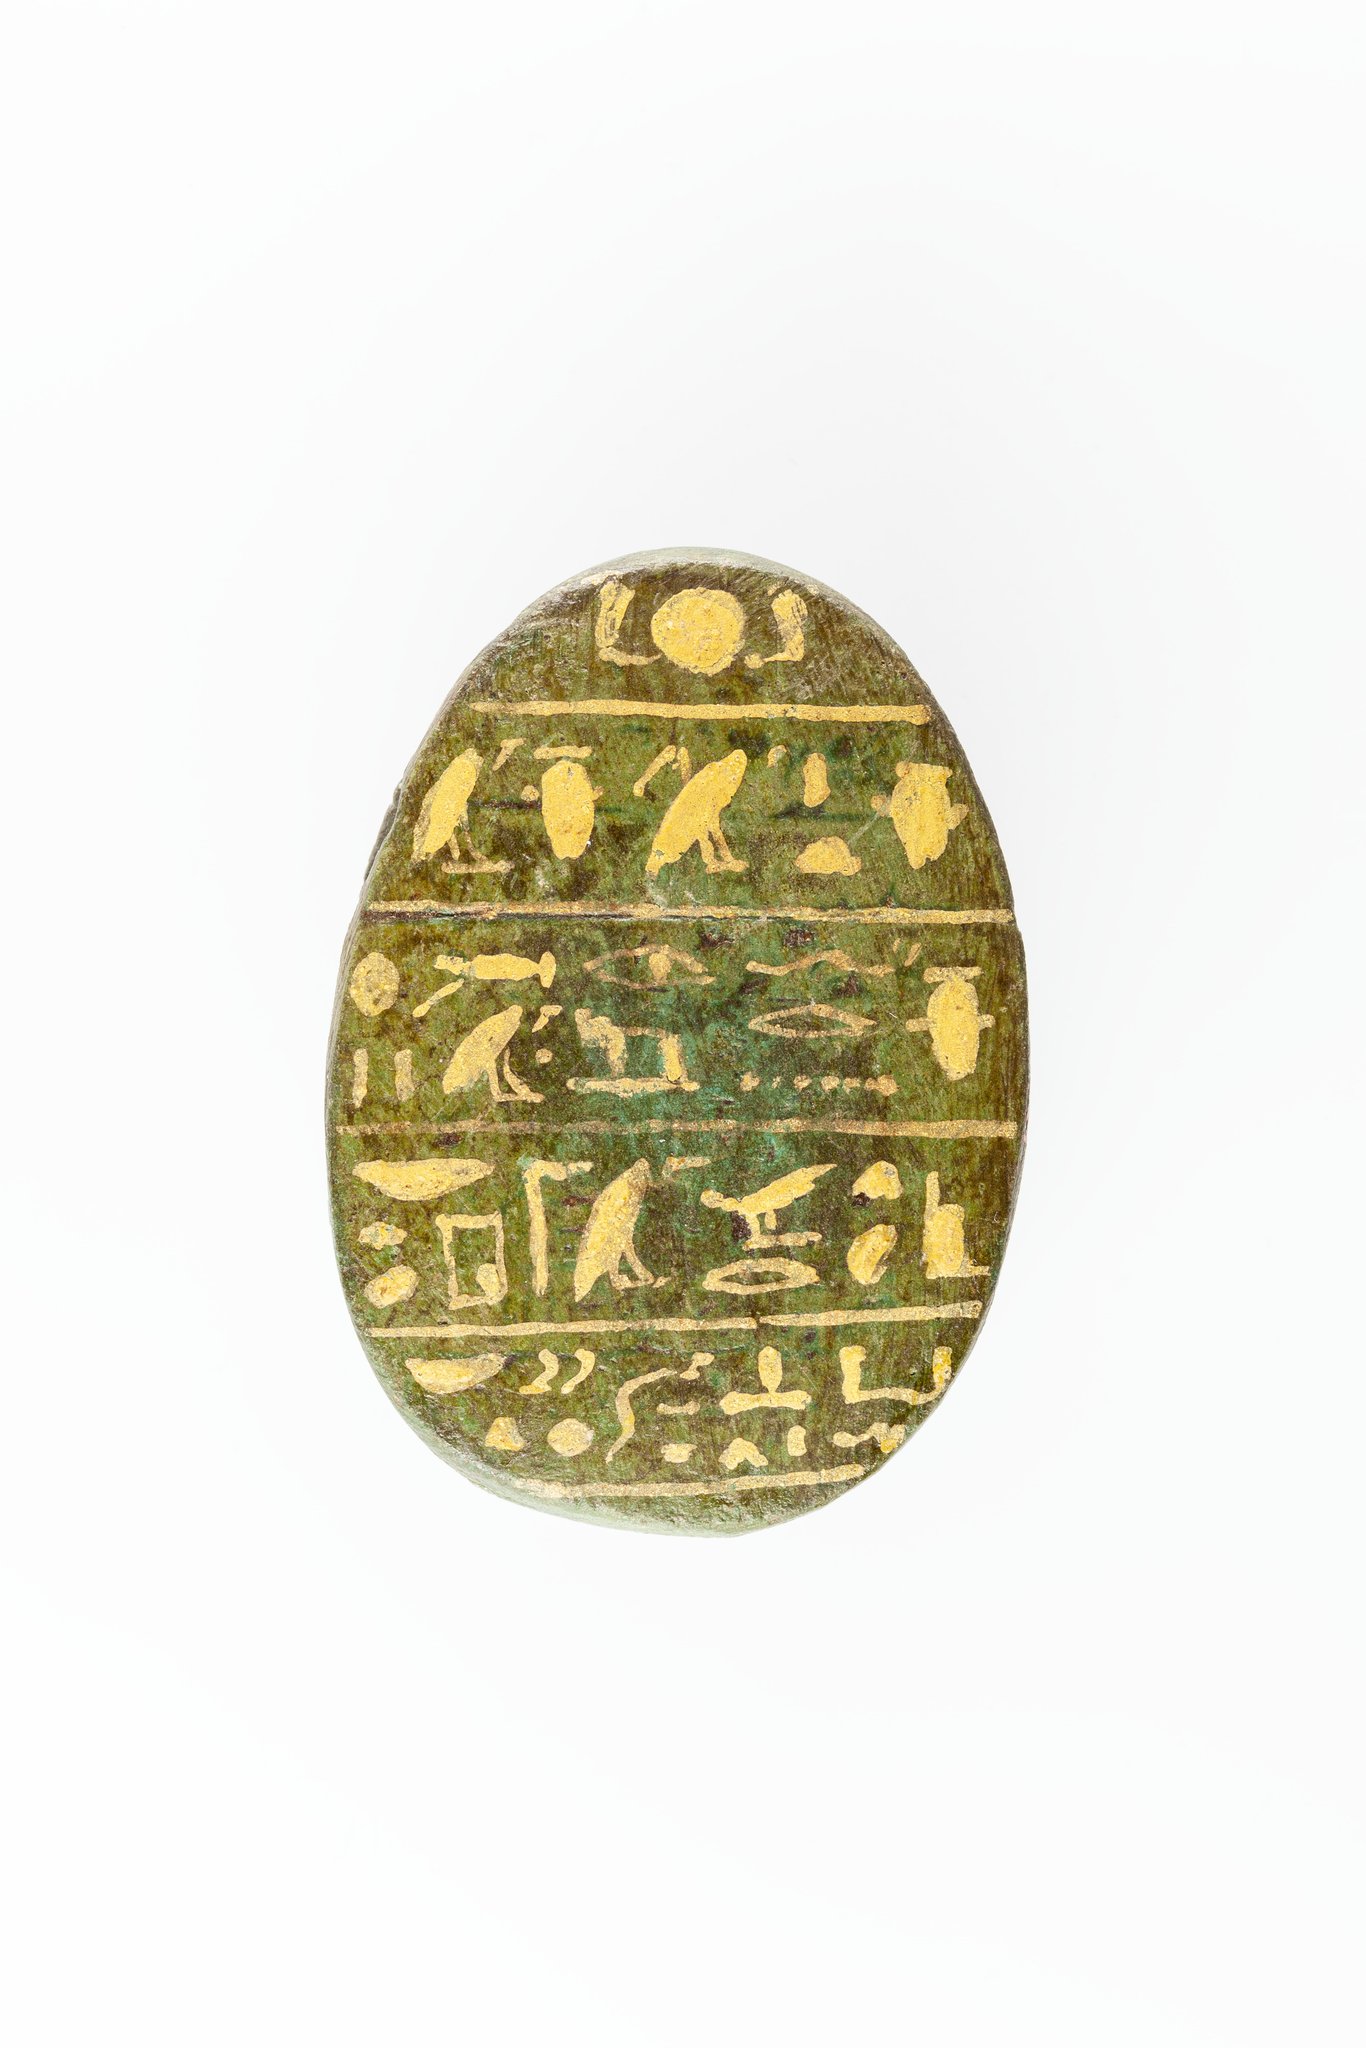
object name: heart scarab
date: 945-525 BCE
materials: faience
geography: egypt